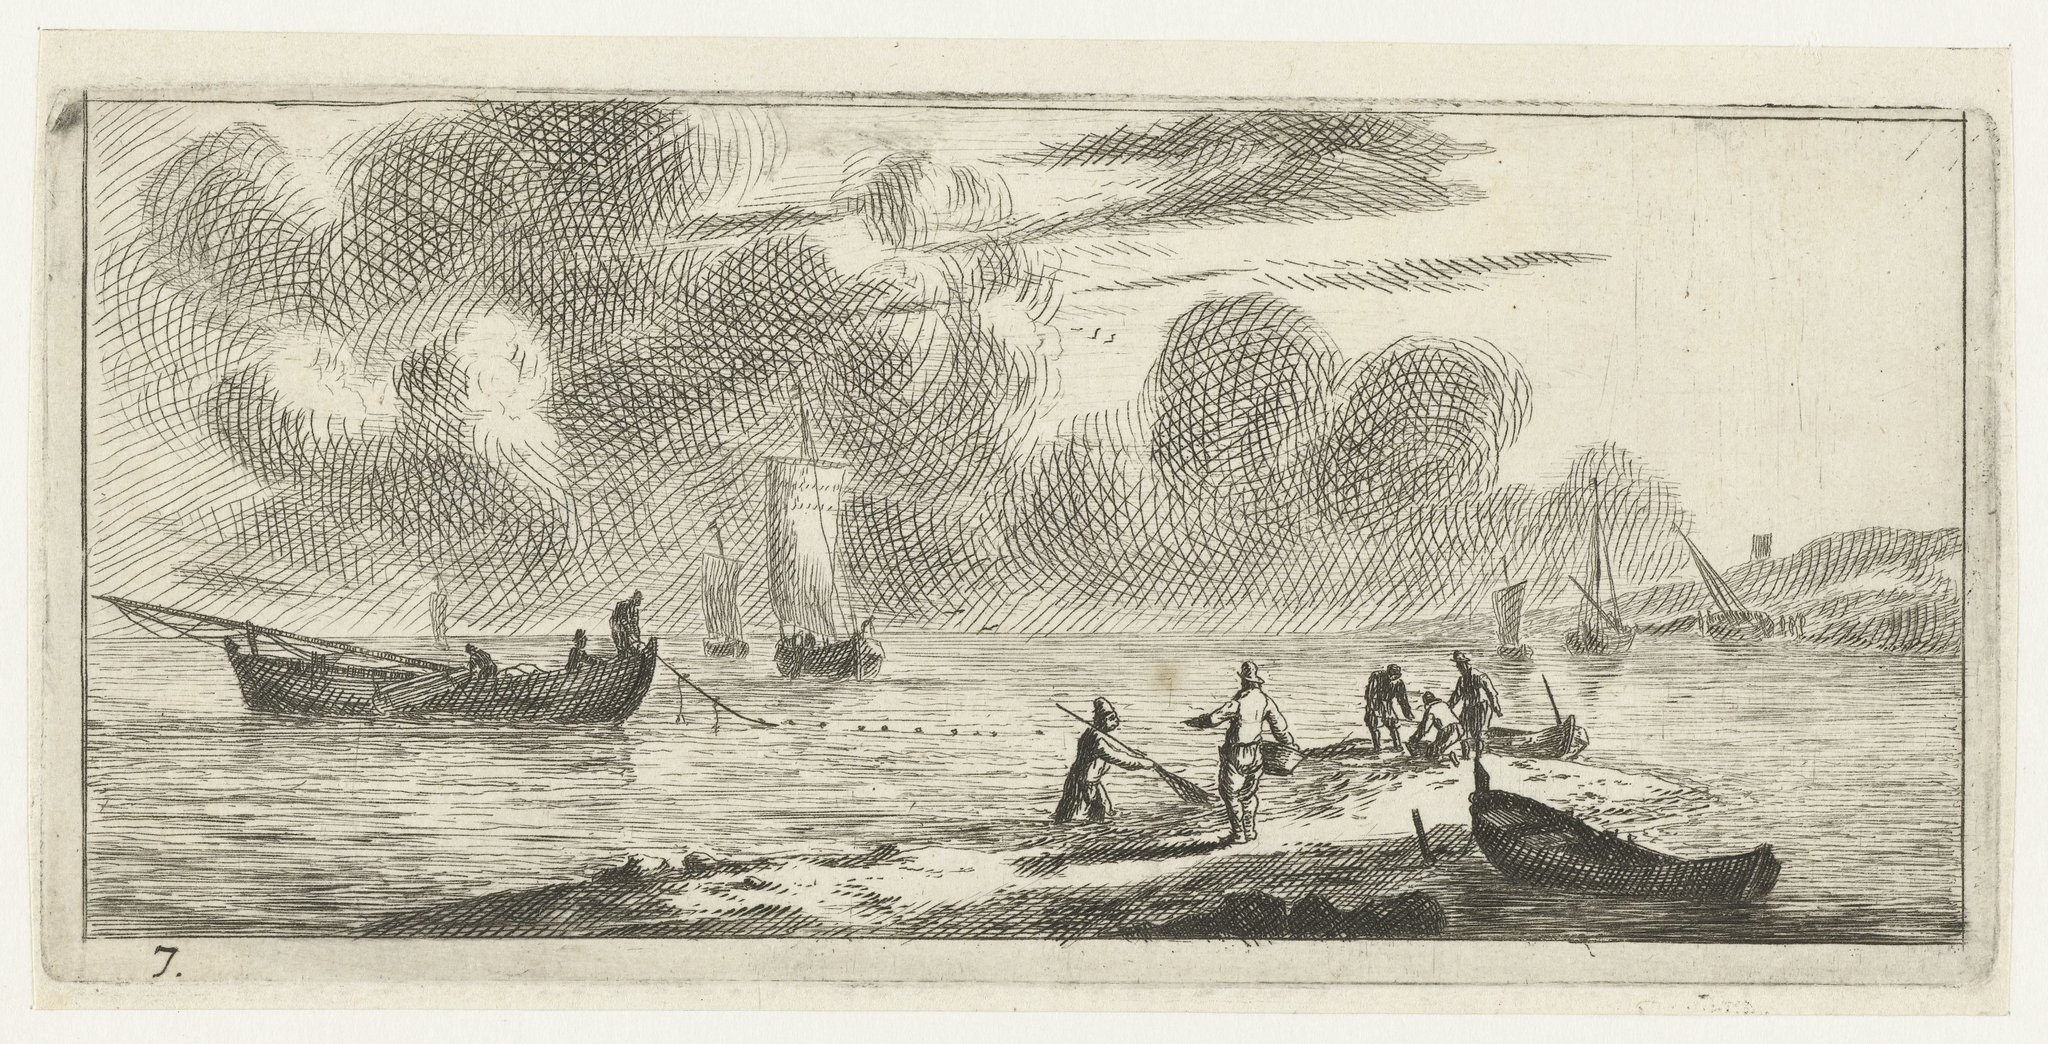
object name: print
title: Kustlijn met mannen vissend in ondiep water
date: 1651-1652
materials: paper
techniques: engraving, etching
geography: amsterdam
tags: sea and coastal fishery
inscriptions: collector's mark: Lugt 2228, collector's mark: Lugt 2760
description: Kustlijn met en vissersboot en vijf vissers met netten en manden in het ondiepe water.